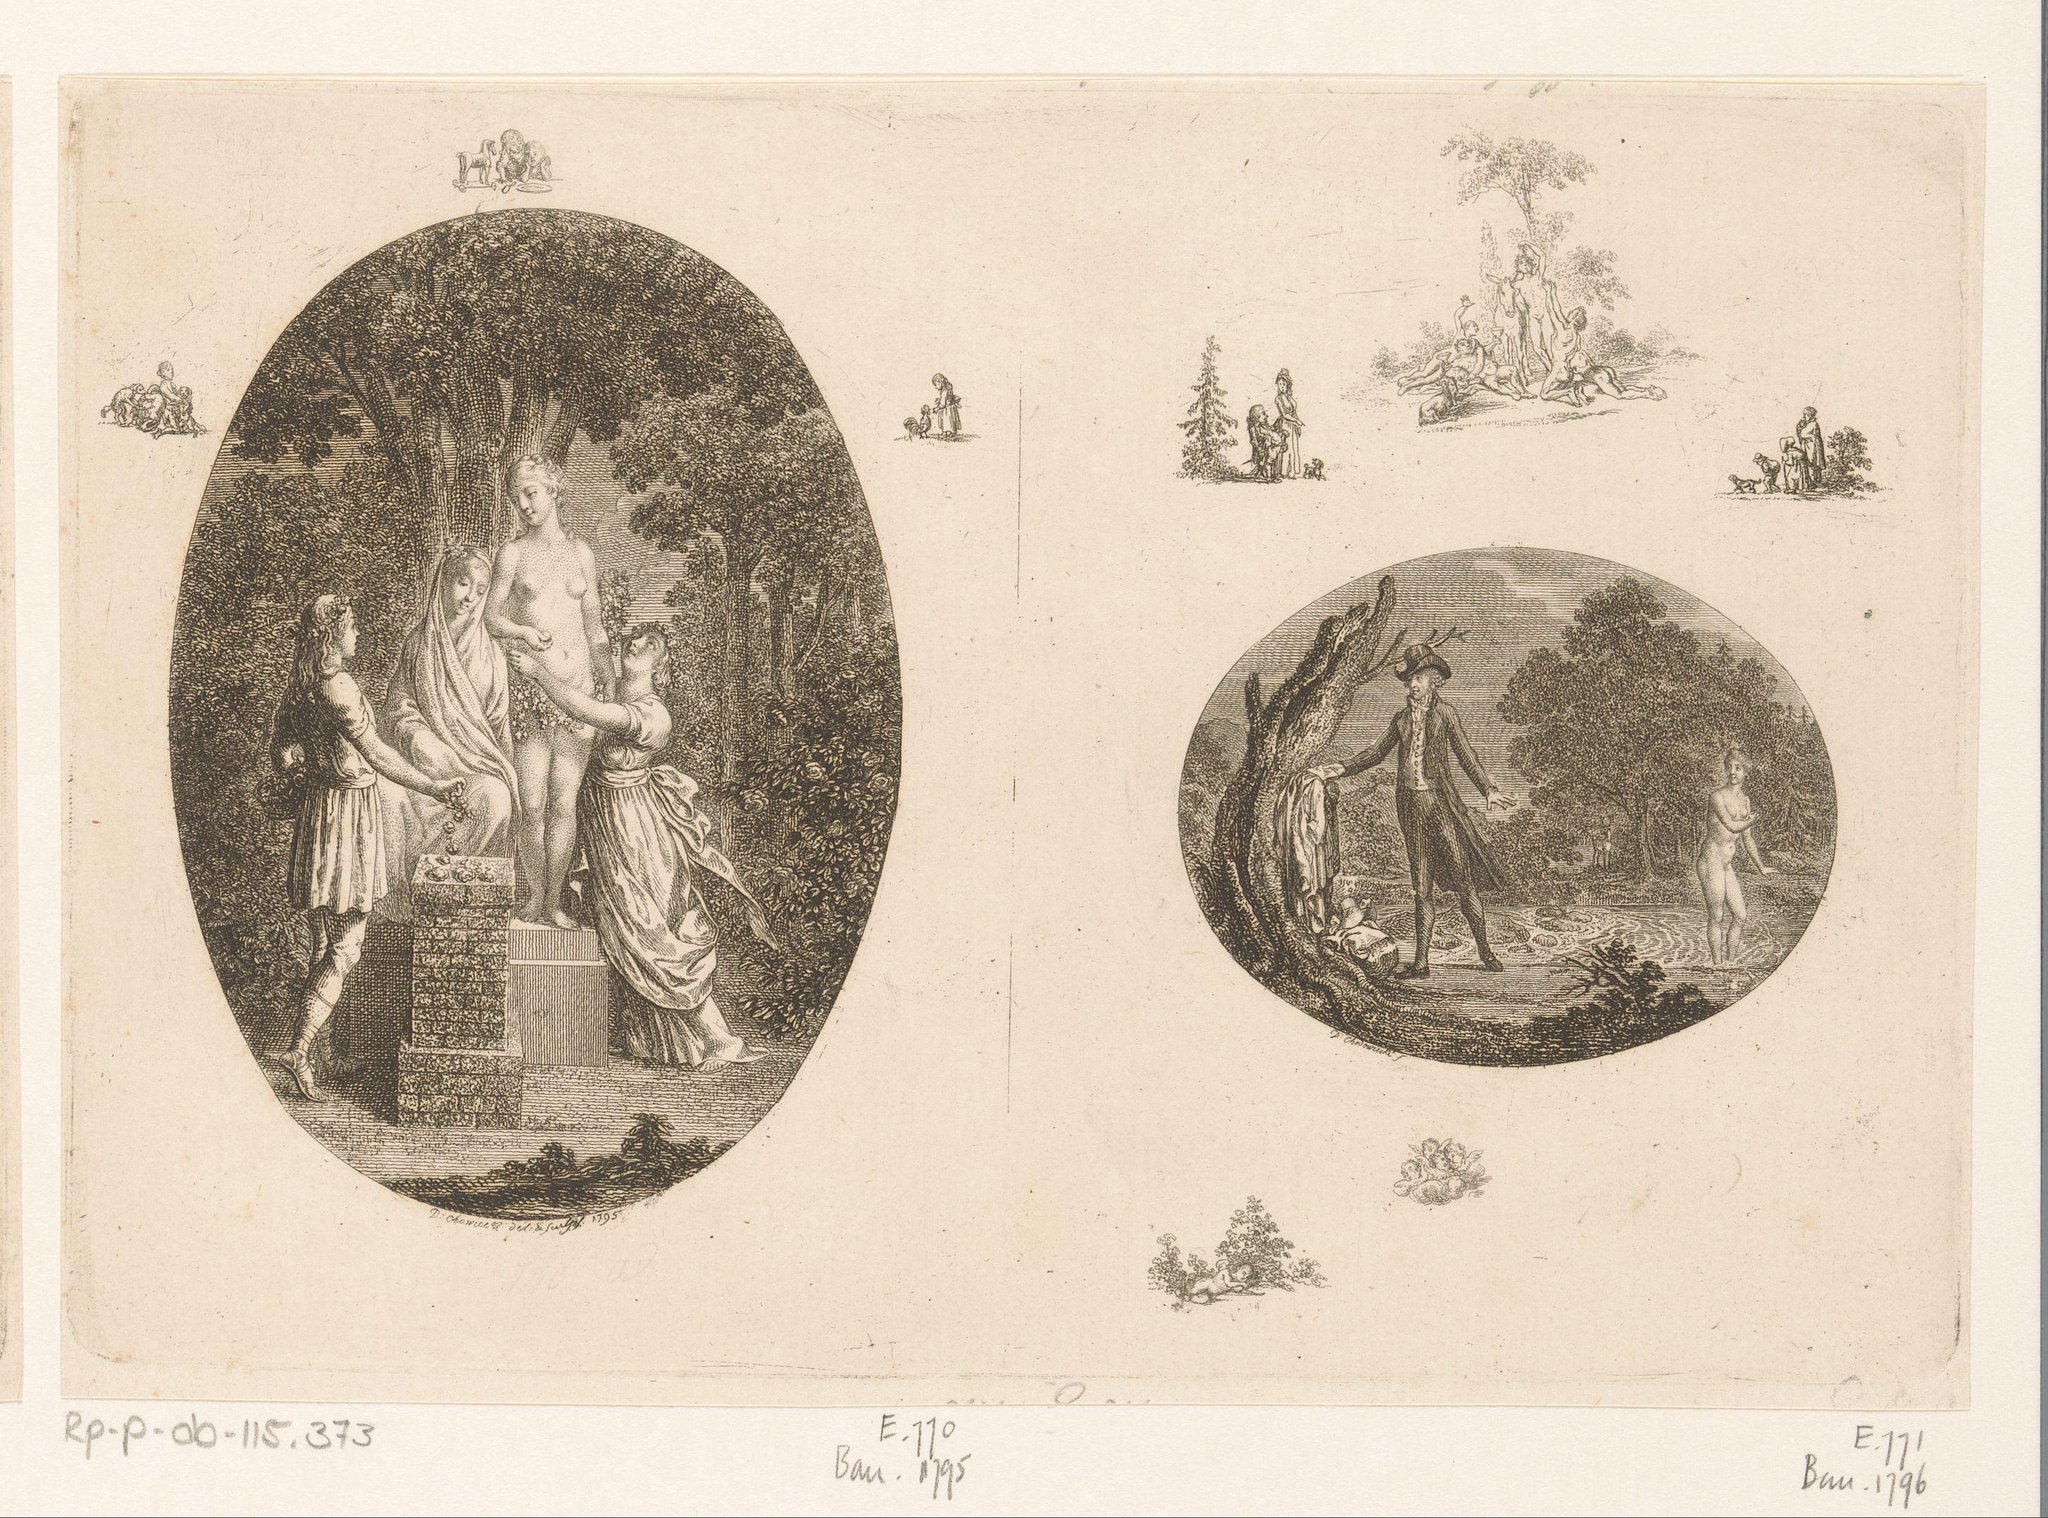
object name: print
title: Twee voorstellingen uit Feyer der Liebe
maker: daniel nikolaus chodowiecki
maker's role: draughtsman, print maker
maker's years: 1726-1801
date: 1795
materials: paper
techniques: etching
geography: berlin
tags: offering; 'offerta overo oblatione' (ripa), garland, wreath, graces (charites), generally three in number; 'gratie' (ripa), monument, statue, (story of) venus (aphrodite), taking a bath - aa - in the open air, letter, envelope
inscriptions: collector's mark: Lugt 2228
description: Links: de verering van de beelden van Venus en een gratie. Rechts: de heer legt een brief bij de kleding van de badende dame. In de marge zijn op schetsmatige wijze verschillende figuren en landschappen geëtst.